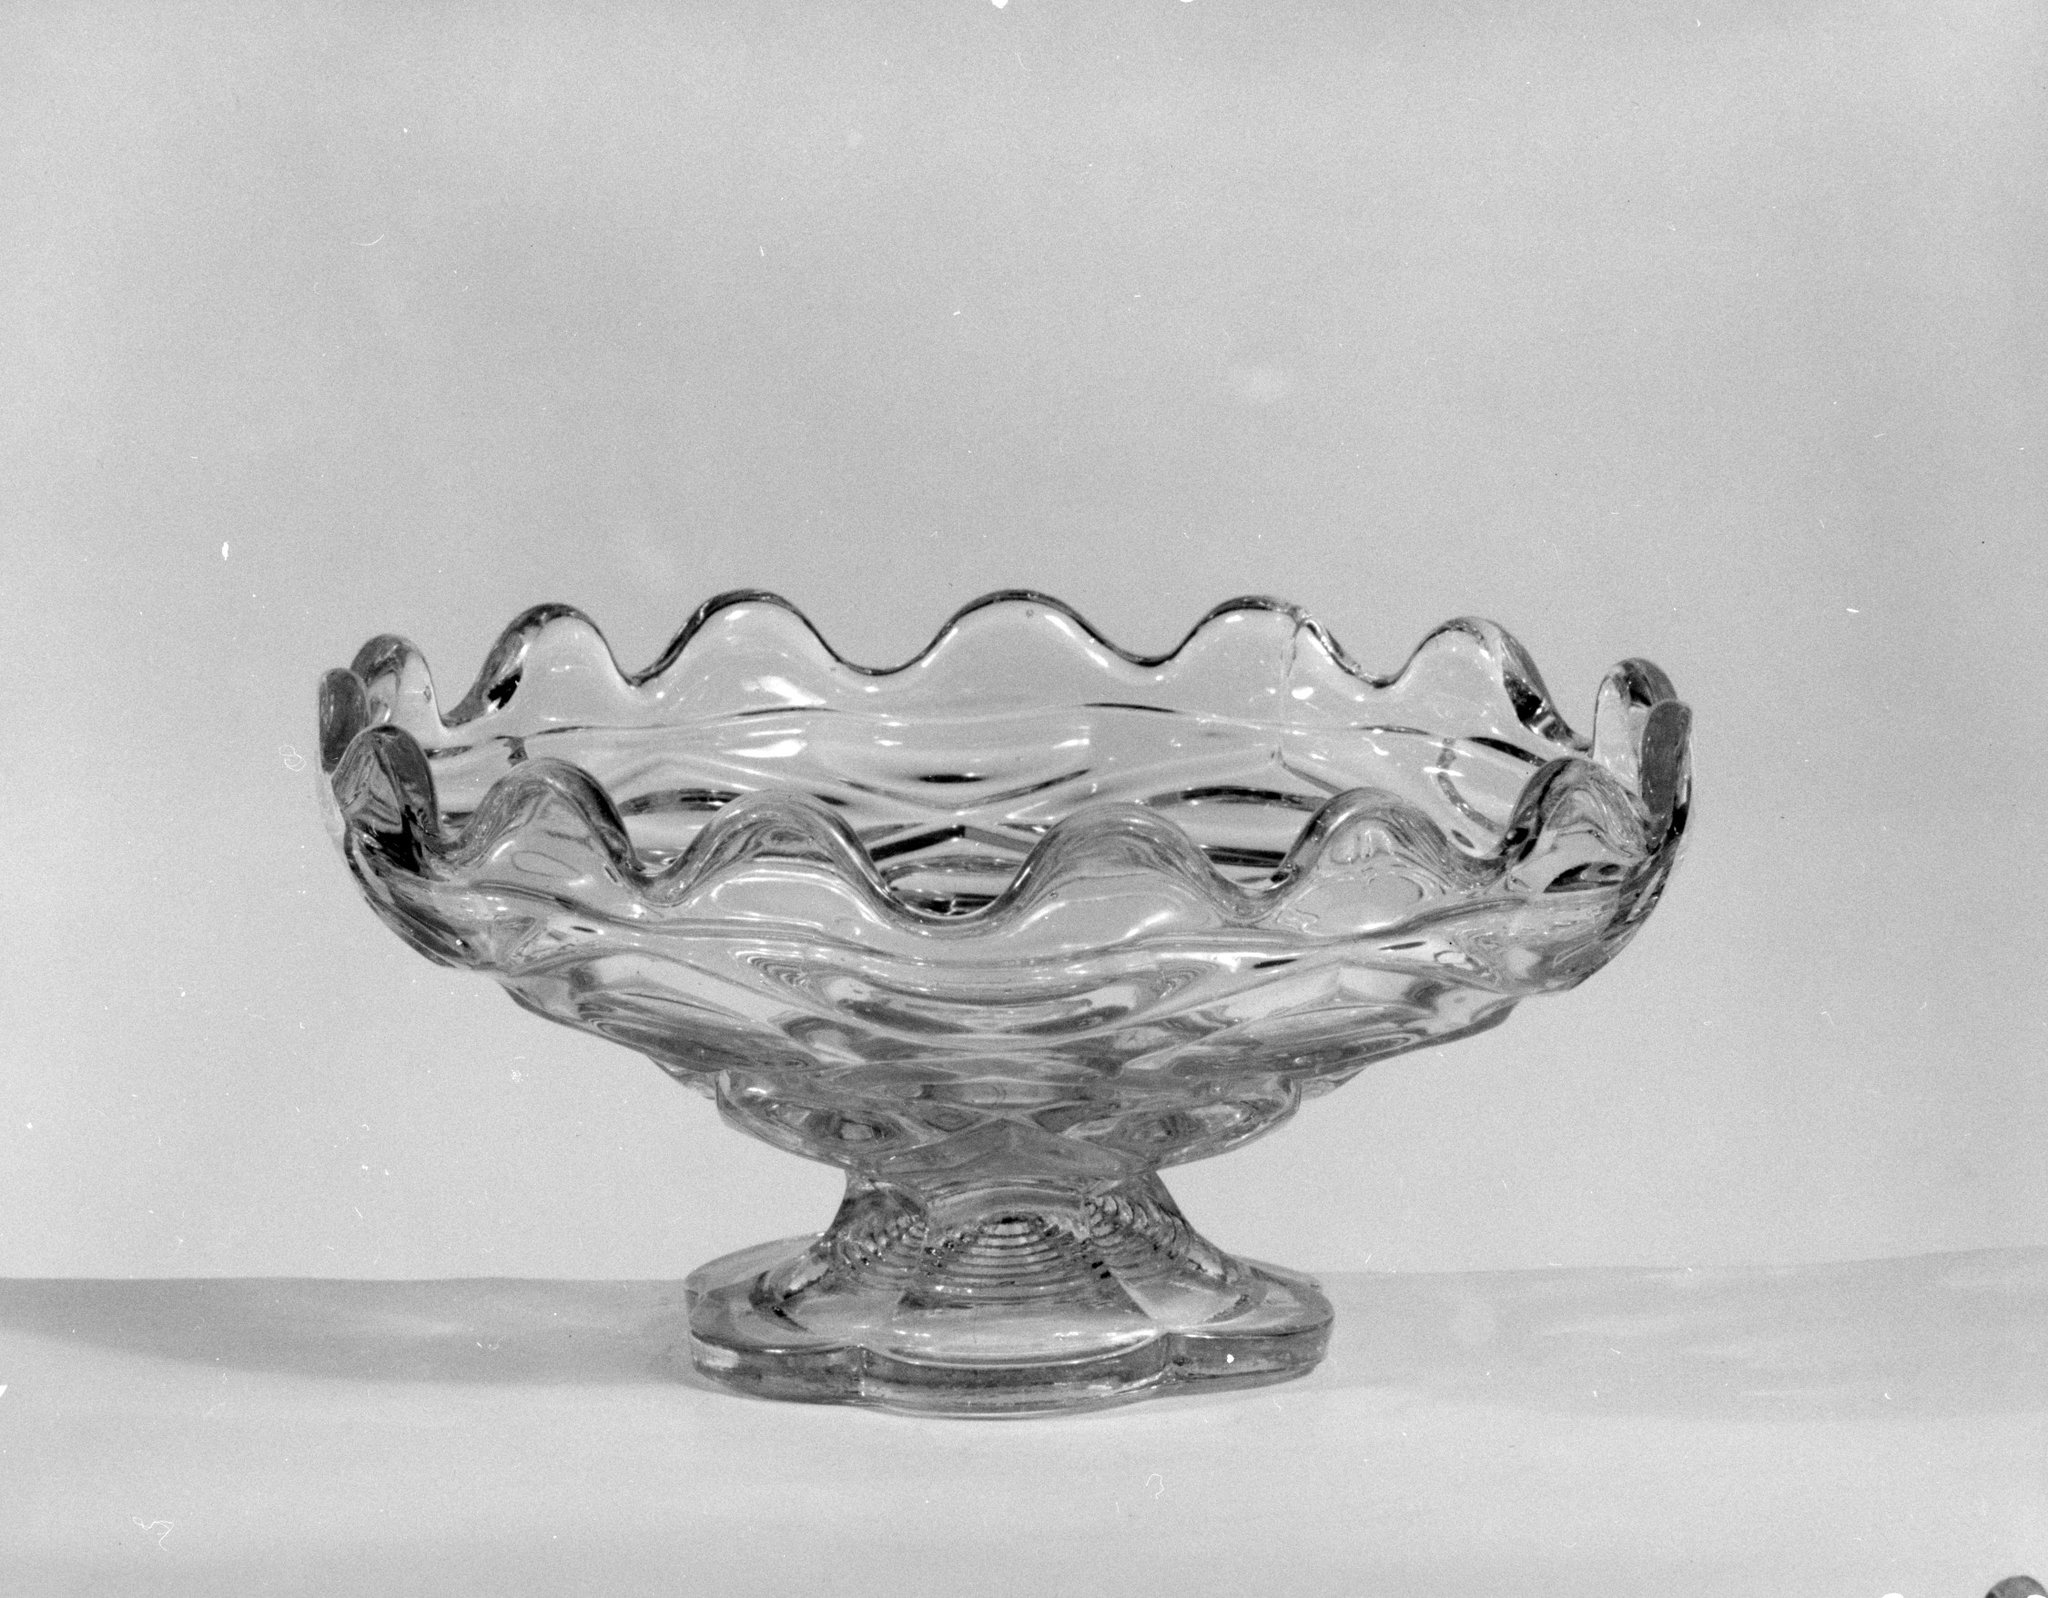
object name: bowl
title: Footed Bowl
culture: american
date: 1850-1870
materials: glass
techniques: pressed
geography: united states